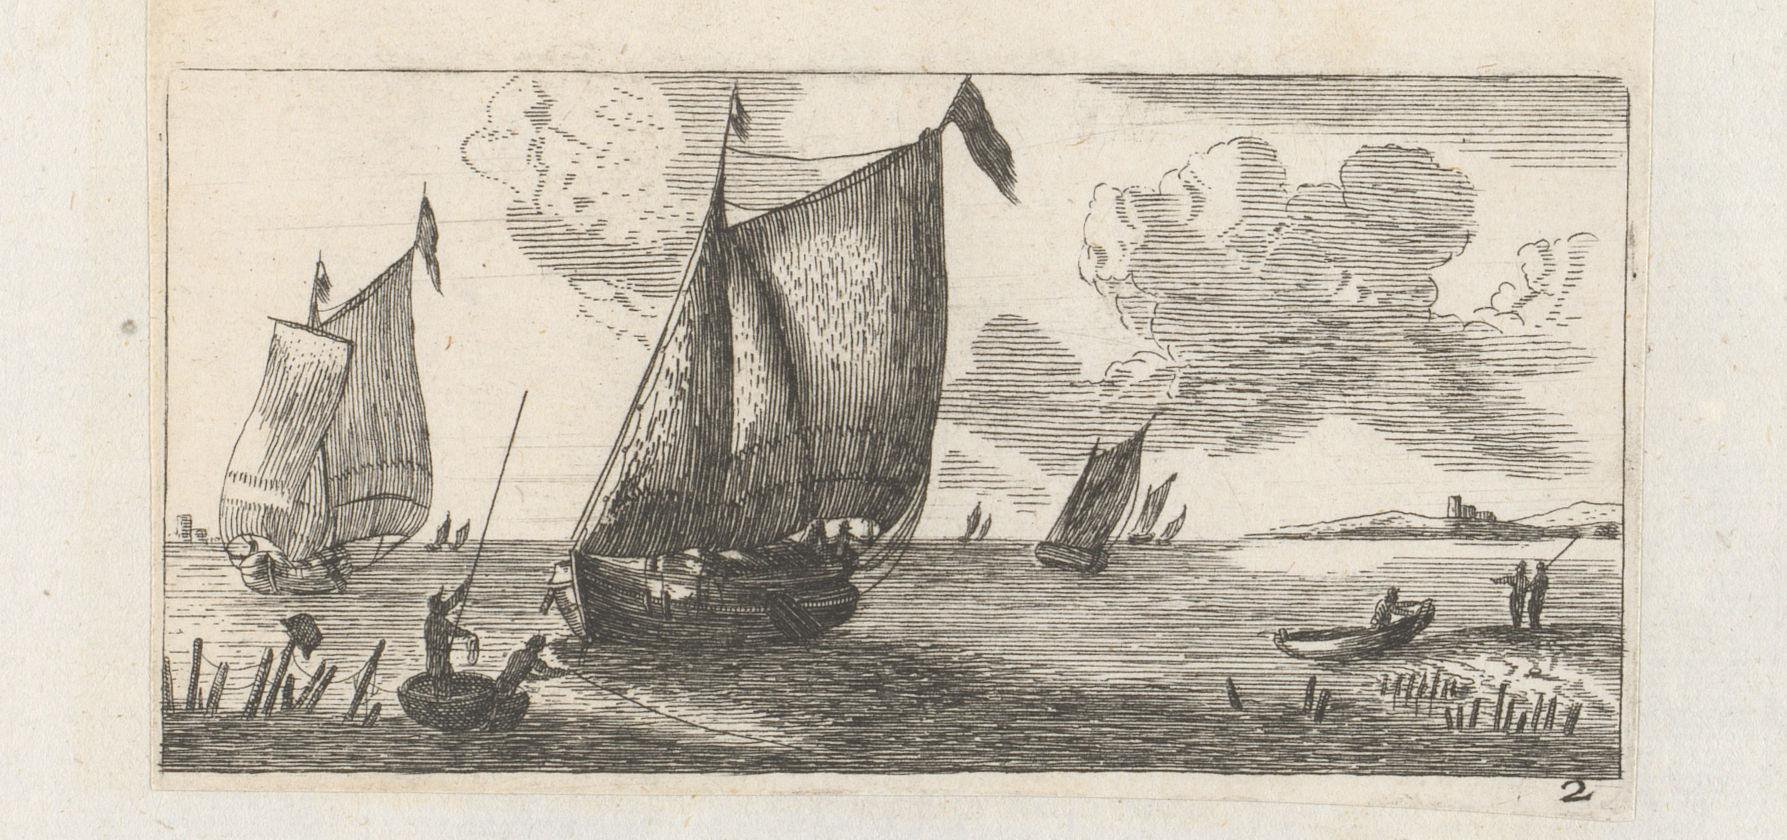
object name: print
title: Zeegezichten met zeilschepen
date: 1686-1724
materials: paper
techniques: etching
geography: augsburg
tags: sailing-ship, sailing-boat, coastal cliff or crag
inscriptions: collector's mark: Lugt 2760, collector's mark: Lugt 2228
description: Prent uit een reeks met soortgelijke zeegezichten. Het is onbekend uit hoeveel prenten deze serie in totaal bestaat. Prent gedrukt op één blad met RP-P-1964-1991.